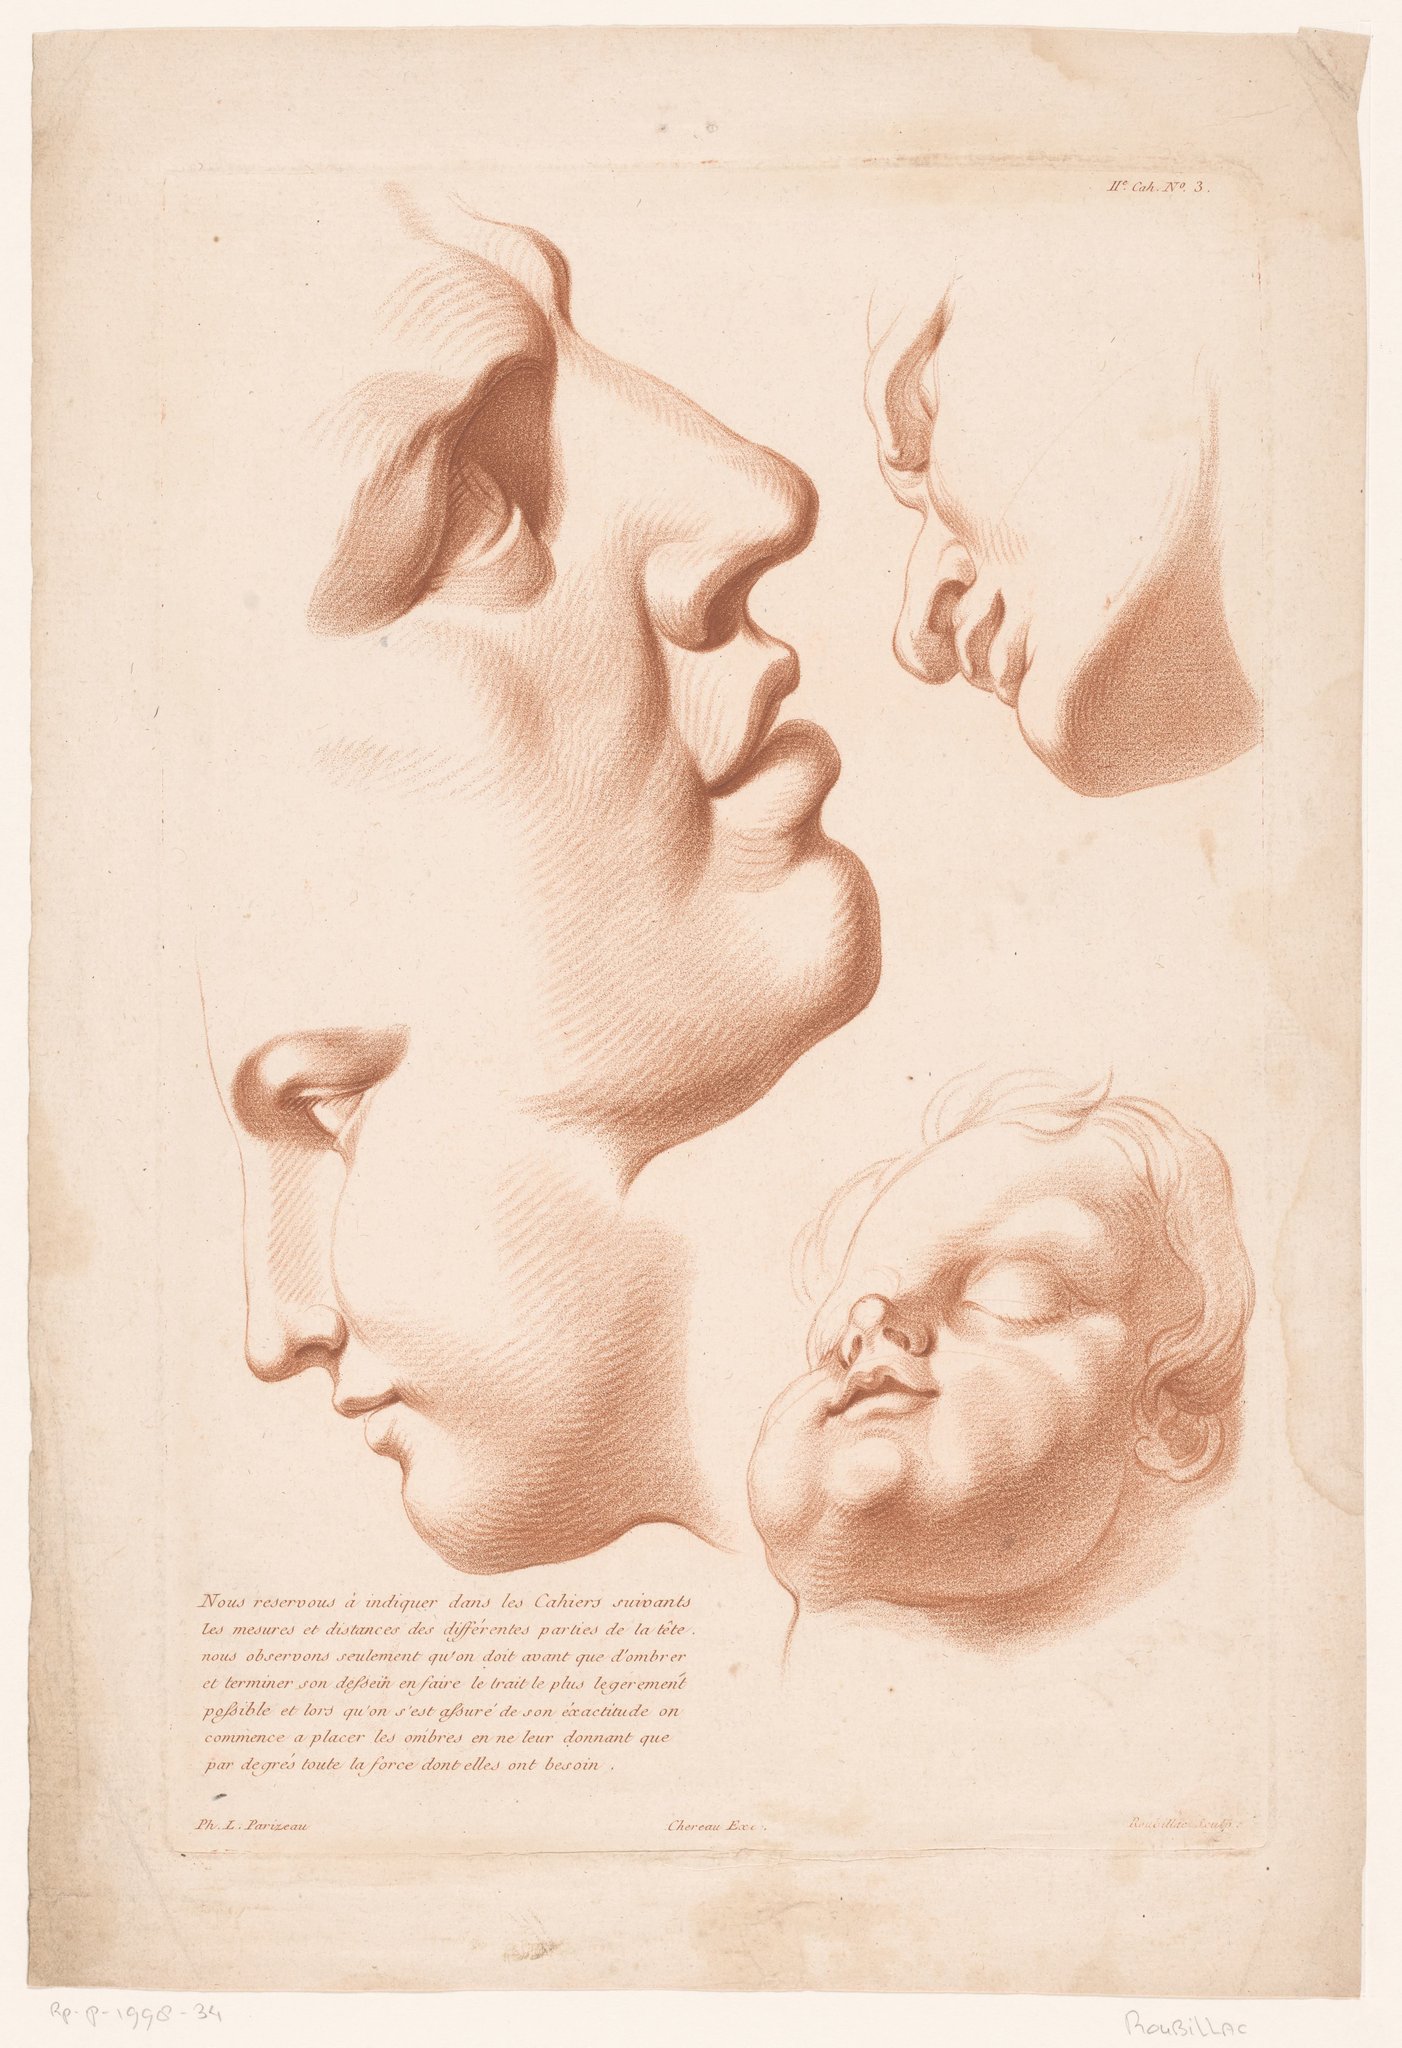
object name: print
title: Principes van het tekenen naar de natuur, deel twee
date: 1780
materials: paper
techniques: printmaking, etching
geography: paris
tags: drawing, sketch, head (human)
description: Compositie met hoofden van een man, een vrouw en een baby.